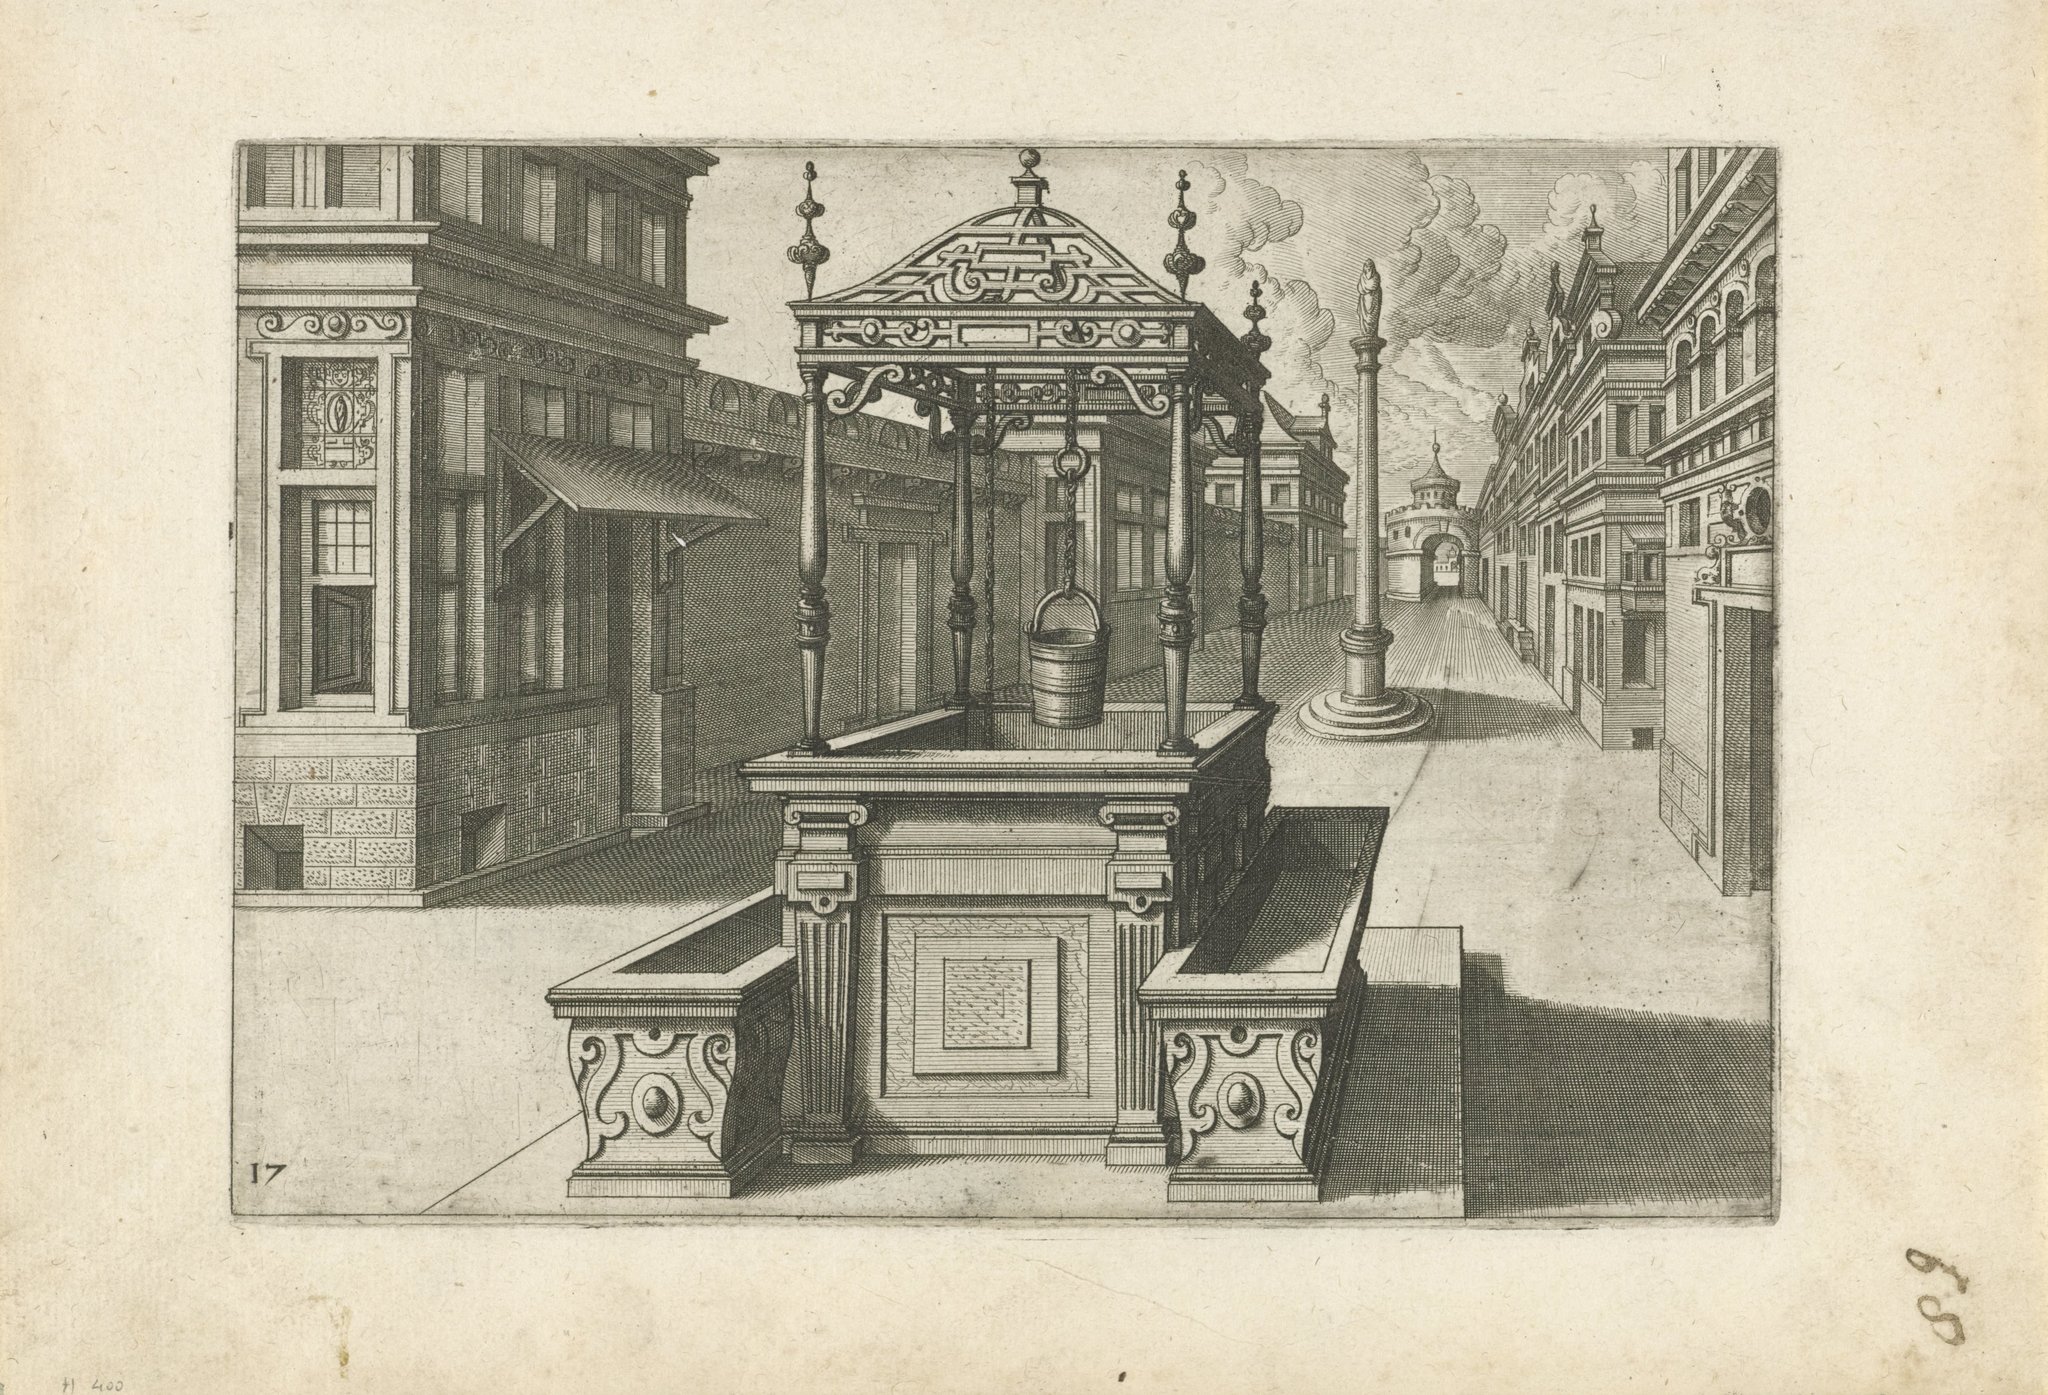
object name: ornament print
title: Waterput met twee lagere langwerpige waterbassins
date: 1574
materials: paper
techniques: etching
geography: antwerp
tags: well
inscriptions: number: ‘17’, inscription: ‘68’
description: Op een stadsplein met zuil staat op de voorgrond een rechthoekige waterput met ijzeren baldakijn dat wordt gedragen door vier balusters. De emmer hangt aan de haak. Links en rechts een rechthoekig laag waterbassin. No.17 uit serie van 24 kleine waterputten